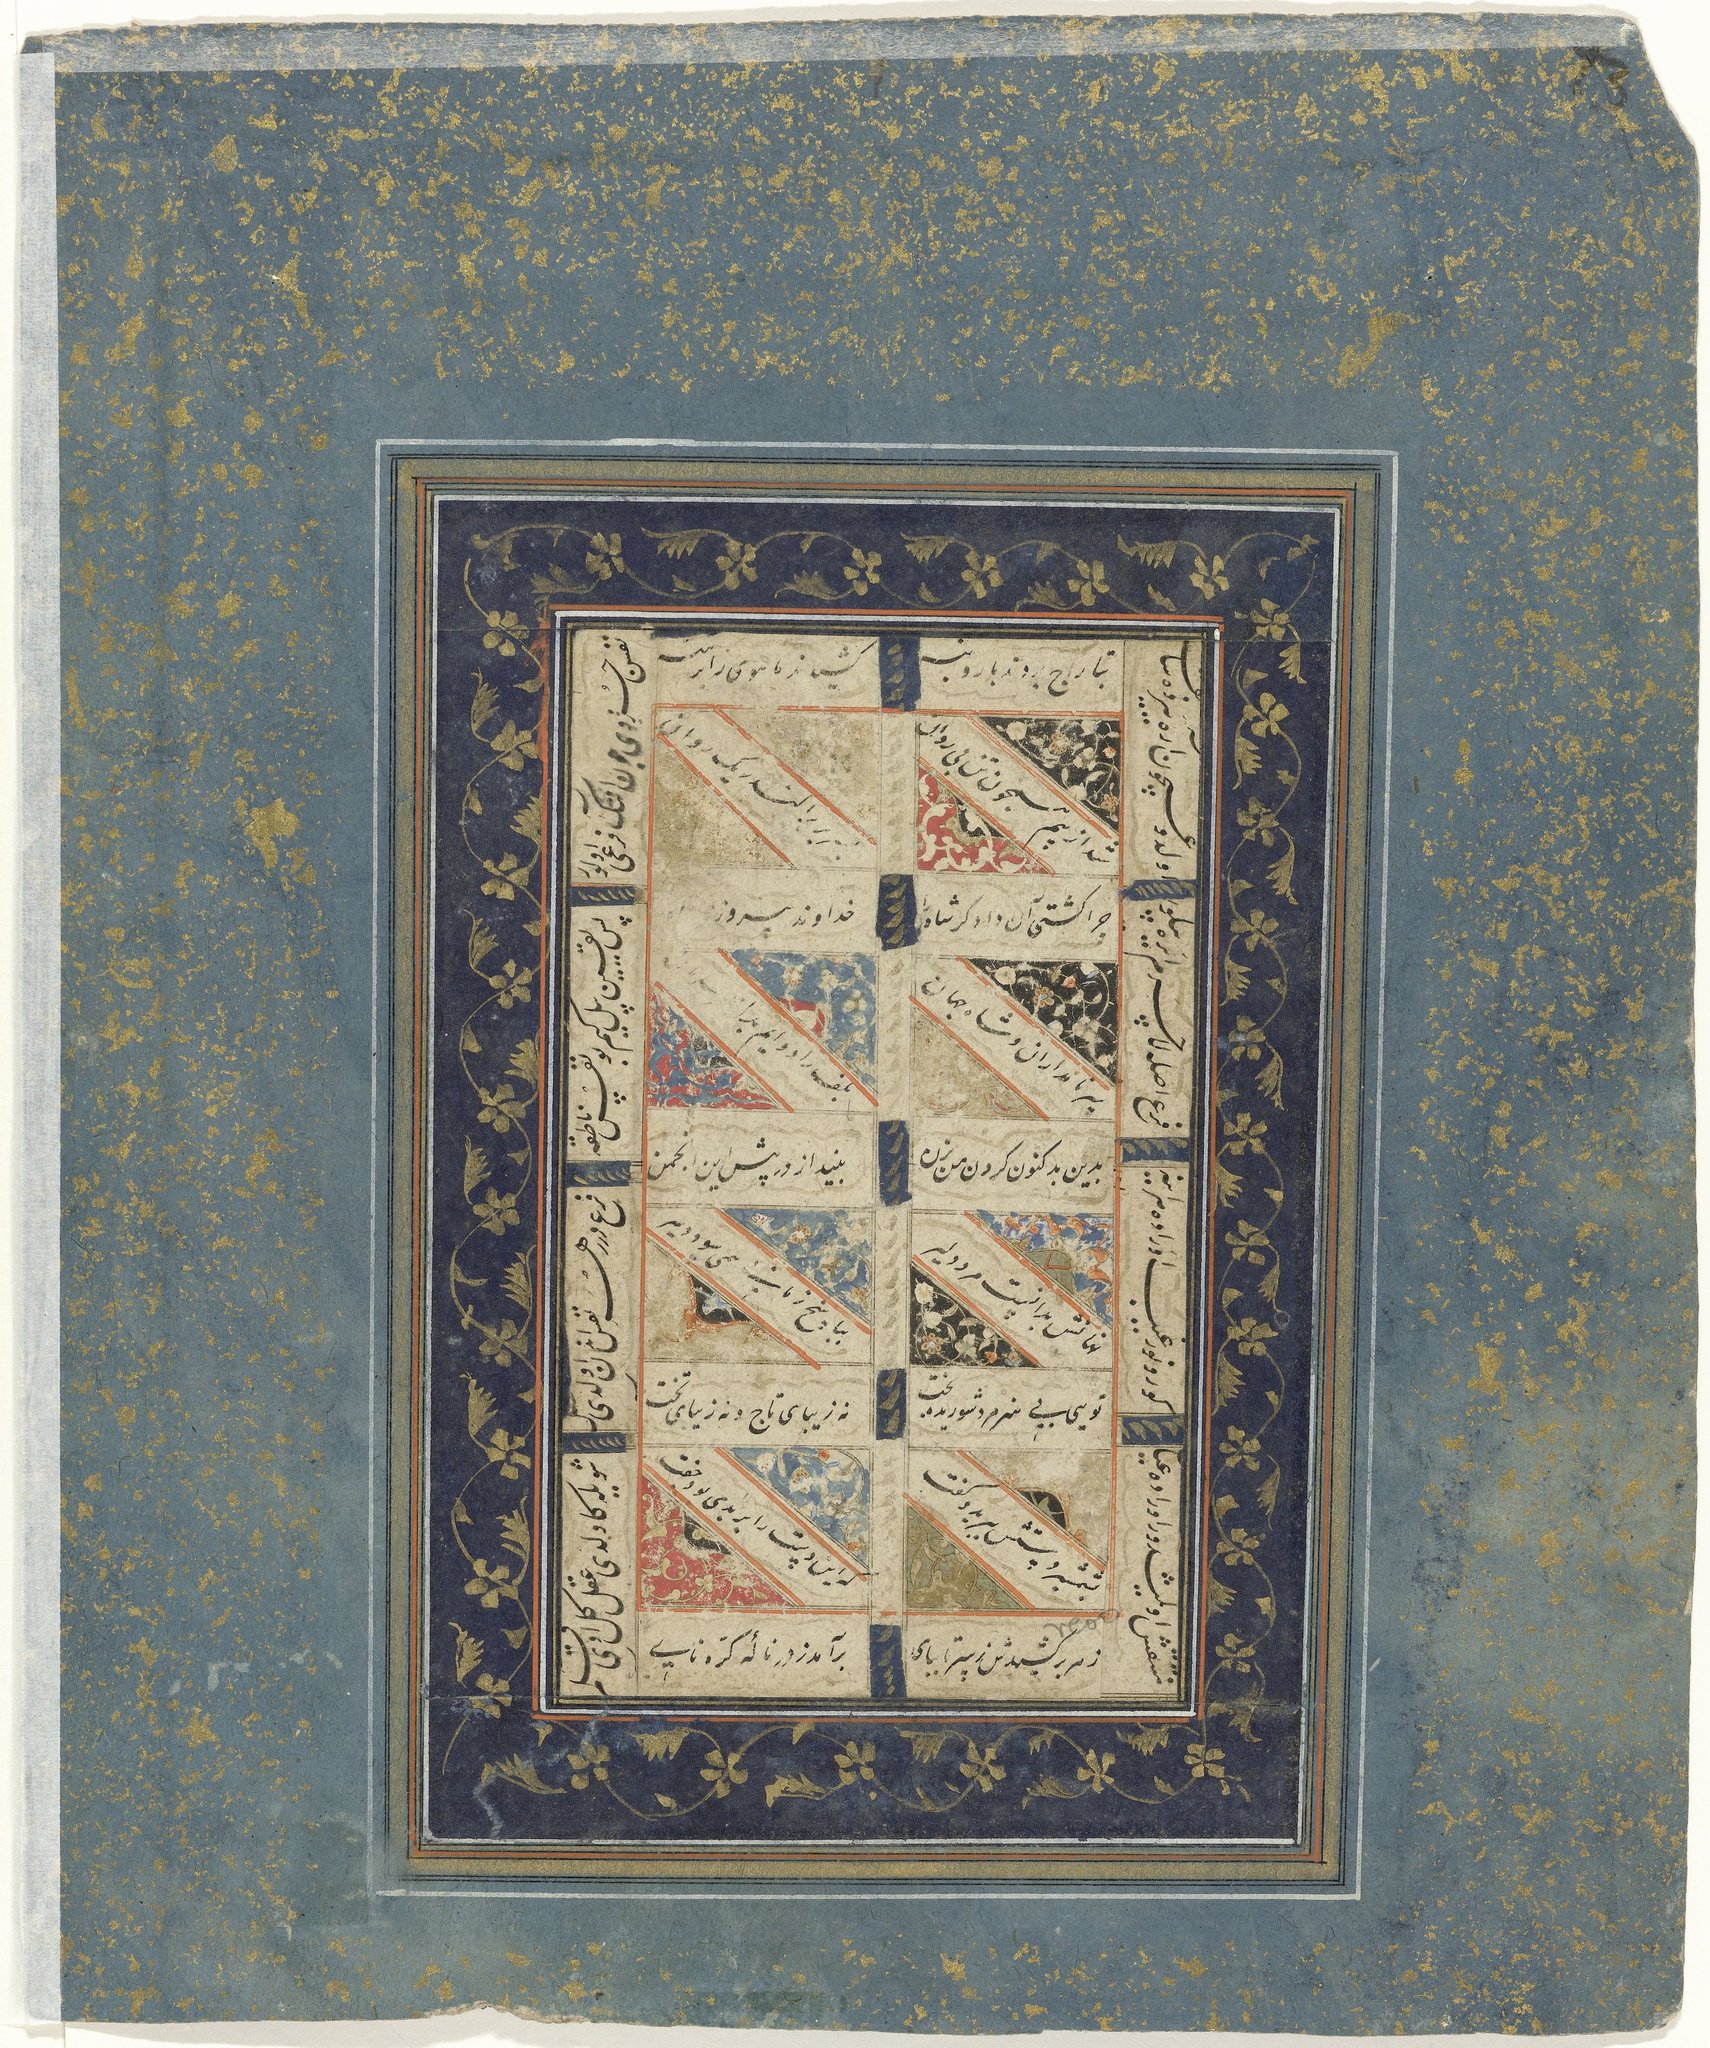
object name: drawing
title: Teksten en bloemornamenten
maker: Anonymous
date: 1740-1760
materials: paper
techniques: brush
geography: india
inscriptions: inscription: ‘.’